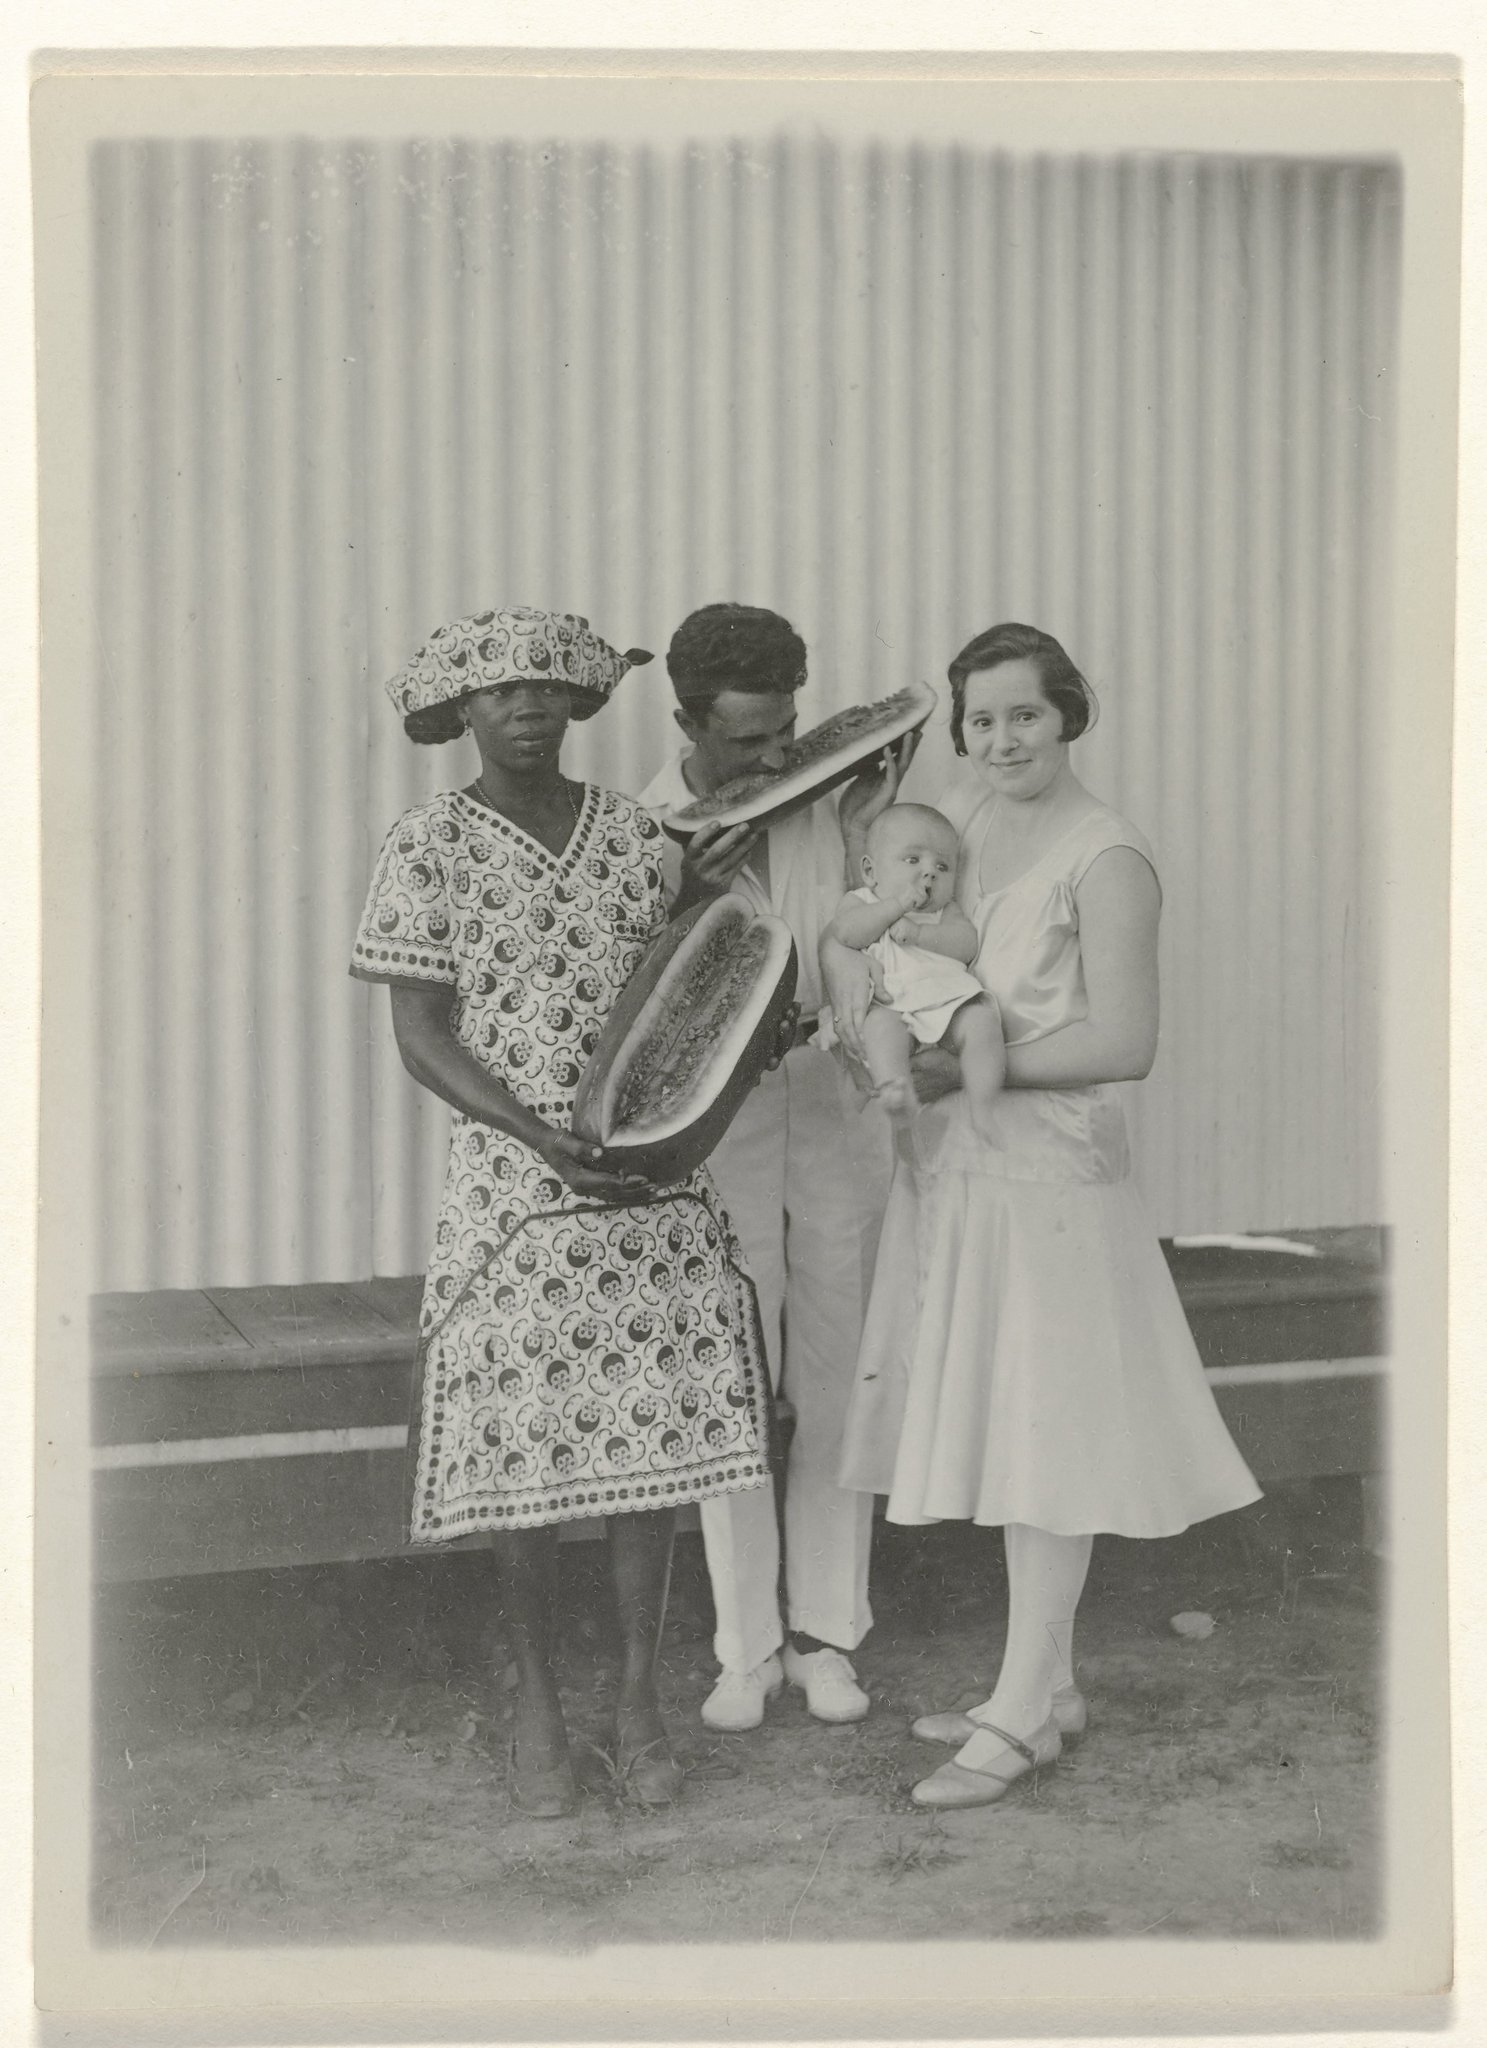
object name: photograph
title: Echtpaar Guilonard met kind en een bediende in Moengo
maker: Anonymous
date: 1930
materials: photographic support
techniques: photography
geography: suriname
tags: fruits: watermelon, family life at home, house personnel, servants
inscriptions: inscription: ‘11 -1 -'30 fam. Guilonard met baby en bediende. Kijk naar de groote watermeloen welke de bediende in de hand houdt.’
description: Mevrouw Guilonard met de baby op de arm, meneer Guilonard etende van een stuk meloen, en een vrouwelijke bediende met de rest van de watermeloen. Opschrift in potlood op achterzijde.